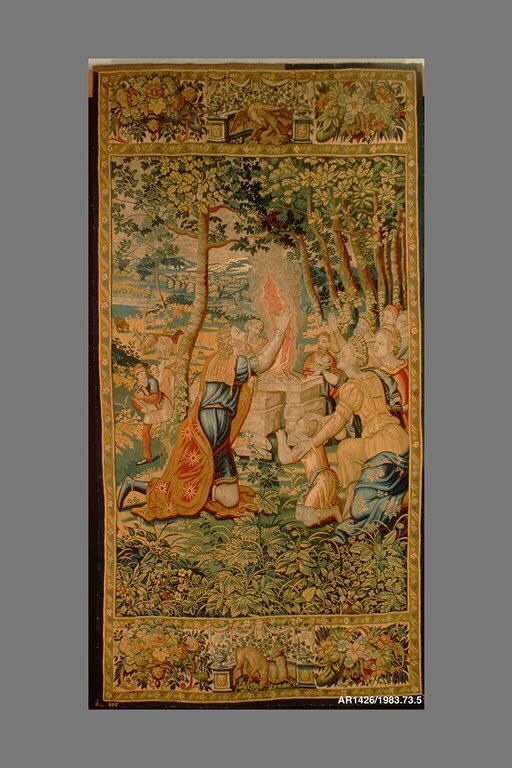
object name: tapestry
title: Jacob Sacrificing After Making a Covenant with Laban from The Story of Jacob series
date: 1550-1575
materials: silk, wool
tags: birds,children,men,women